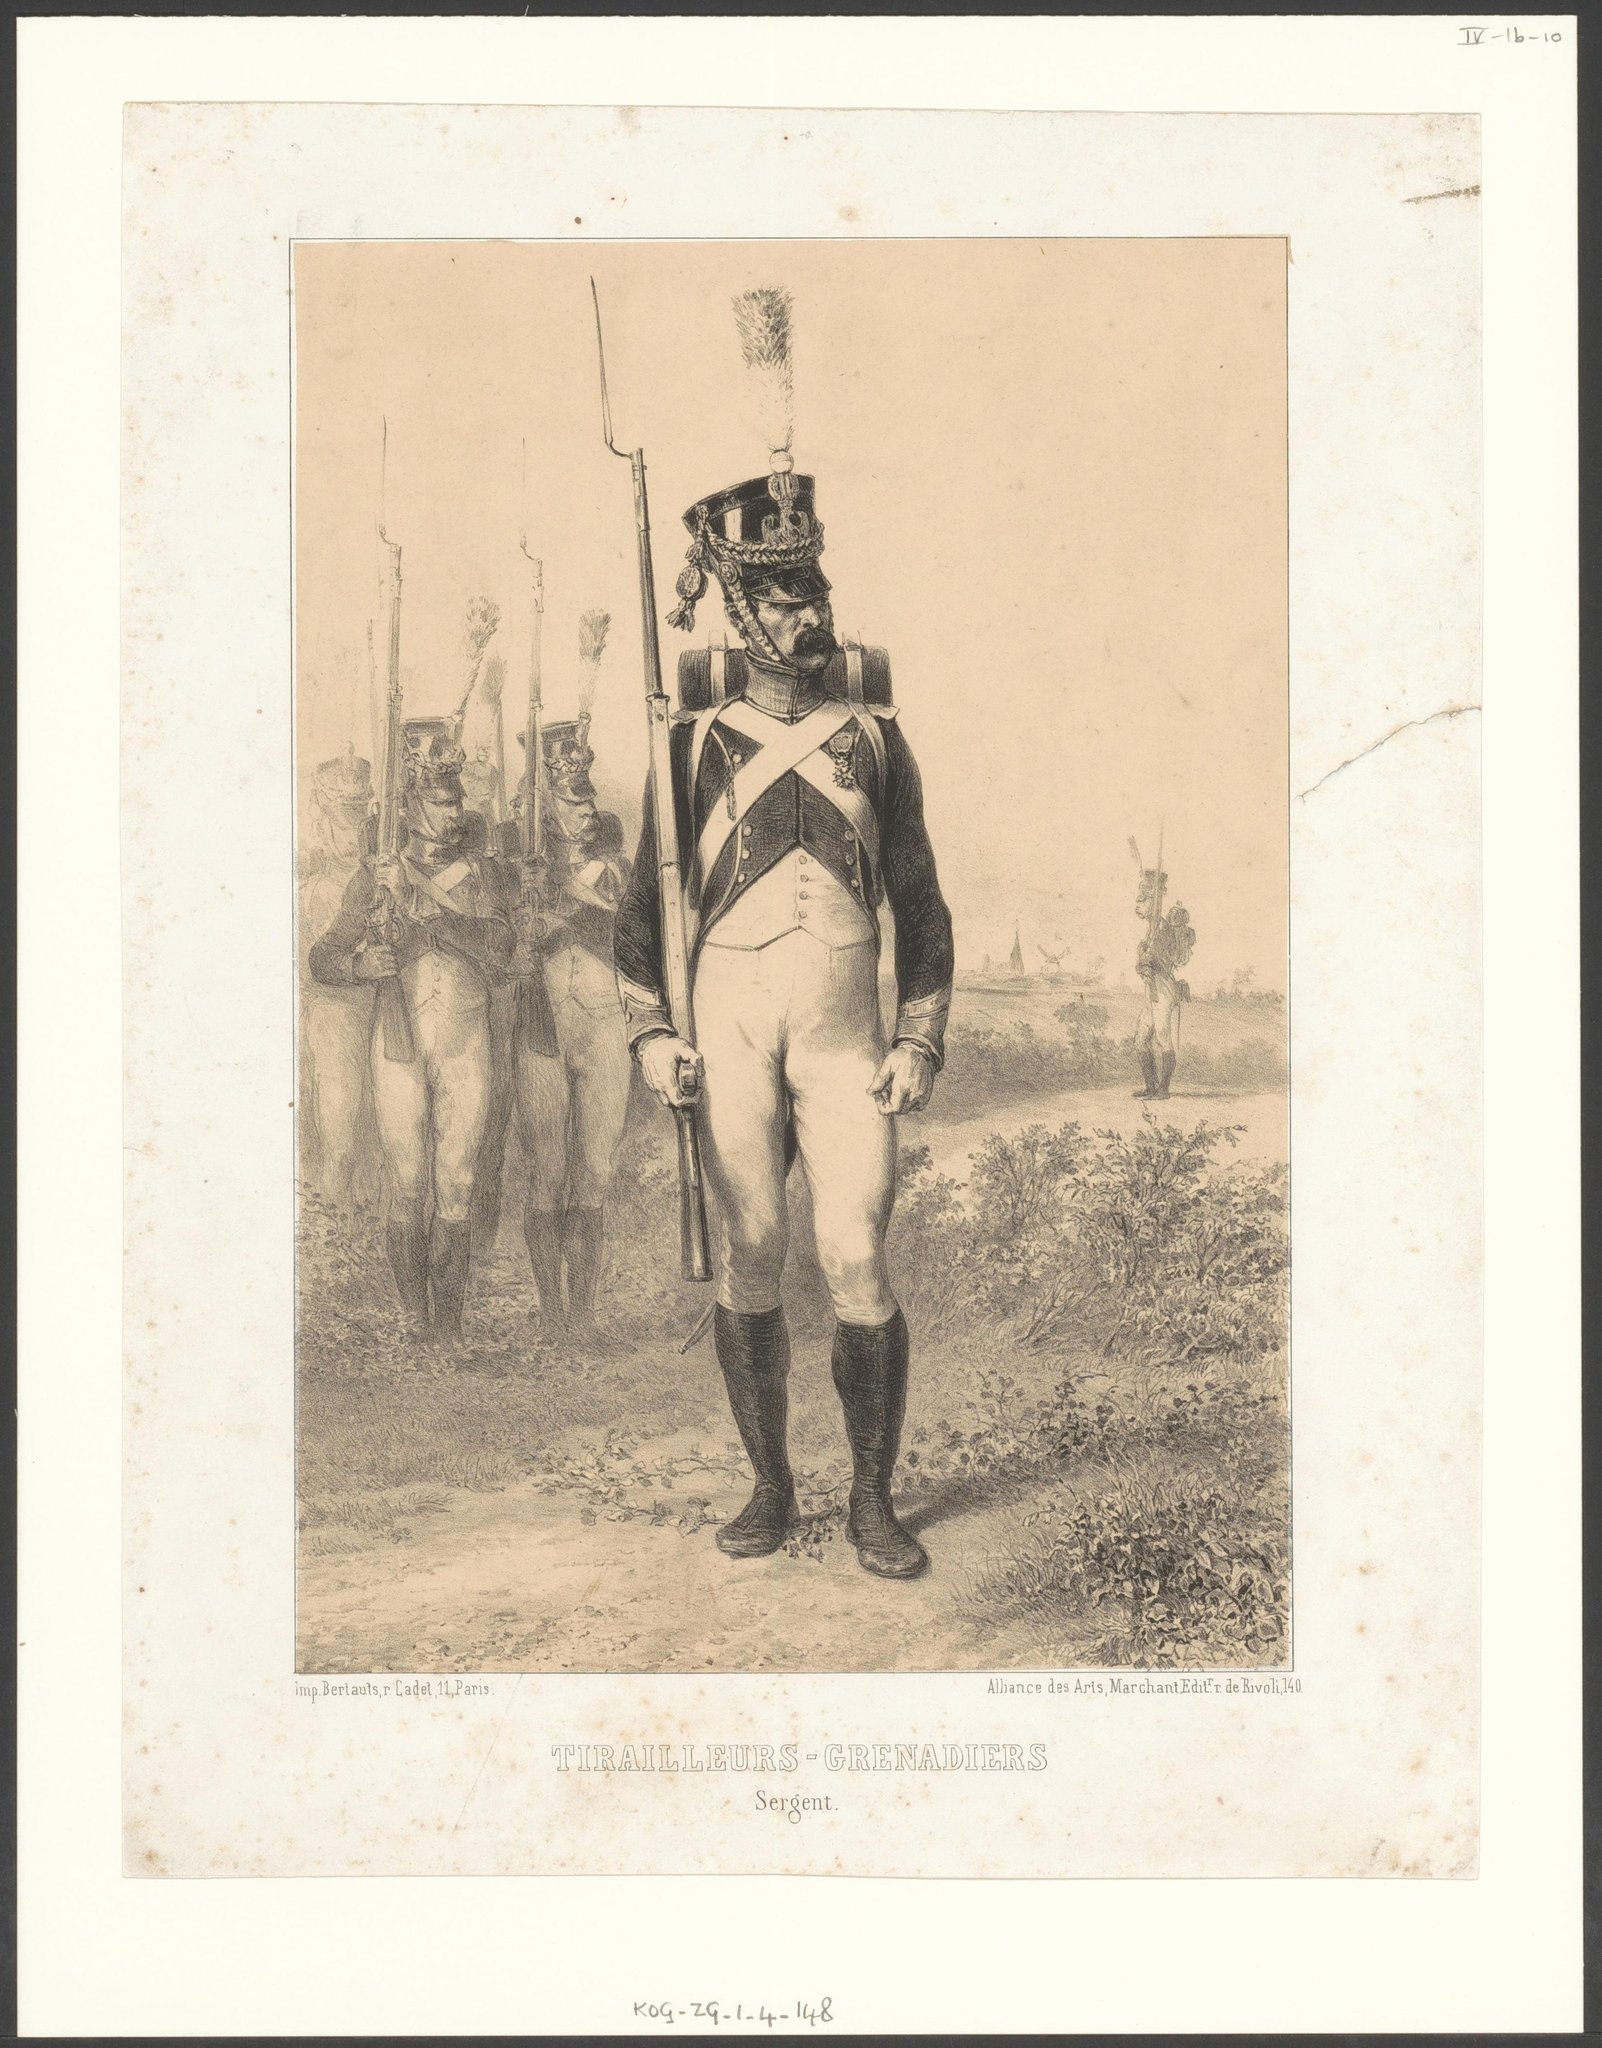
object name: print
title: Tirailleurs-Grenadiers / Sergent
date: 1851-1865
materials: paper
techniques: tone lithography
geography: paris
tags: officer, (military) uniforms